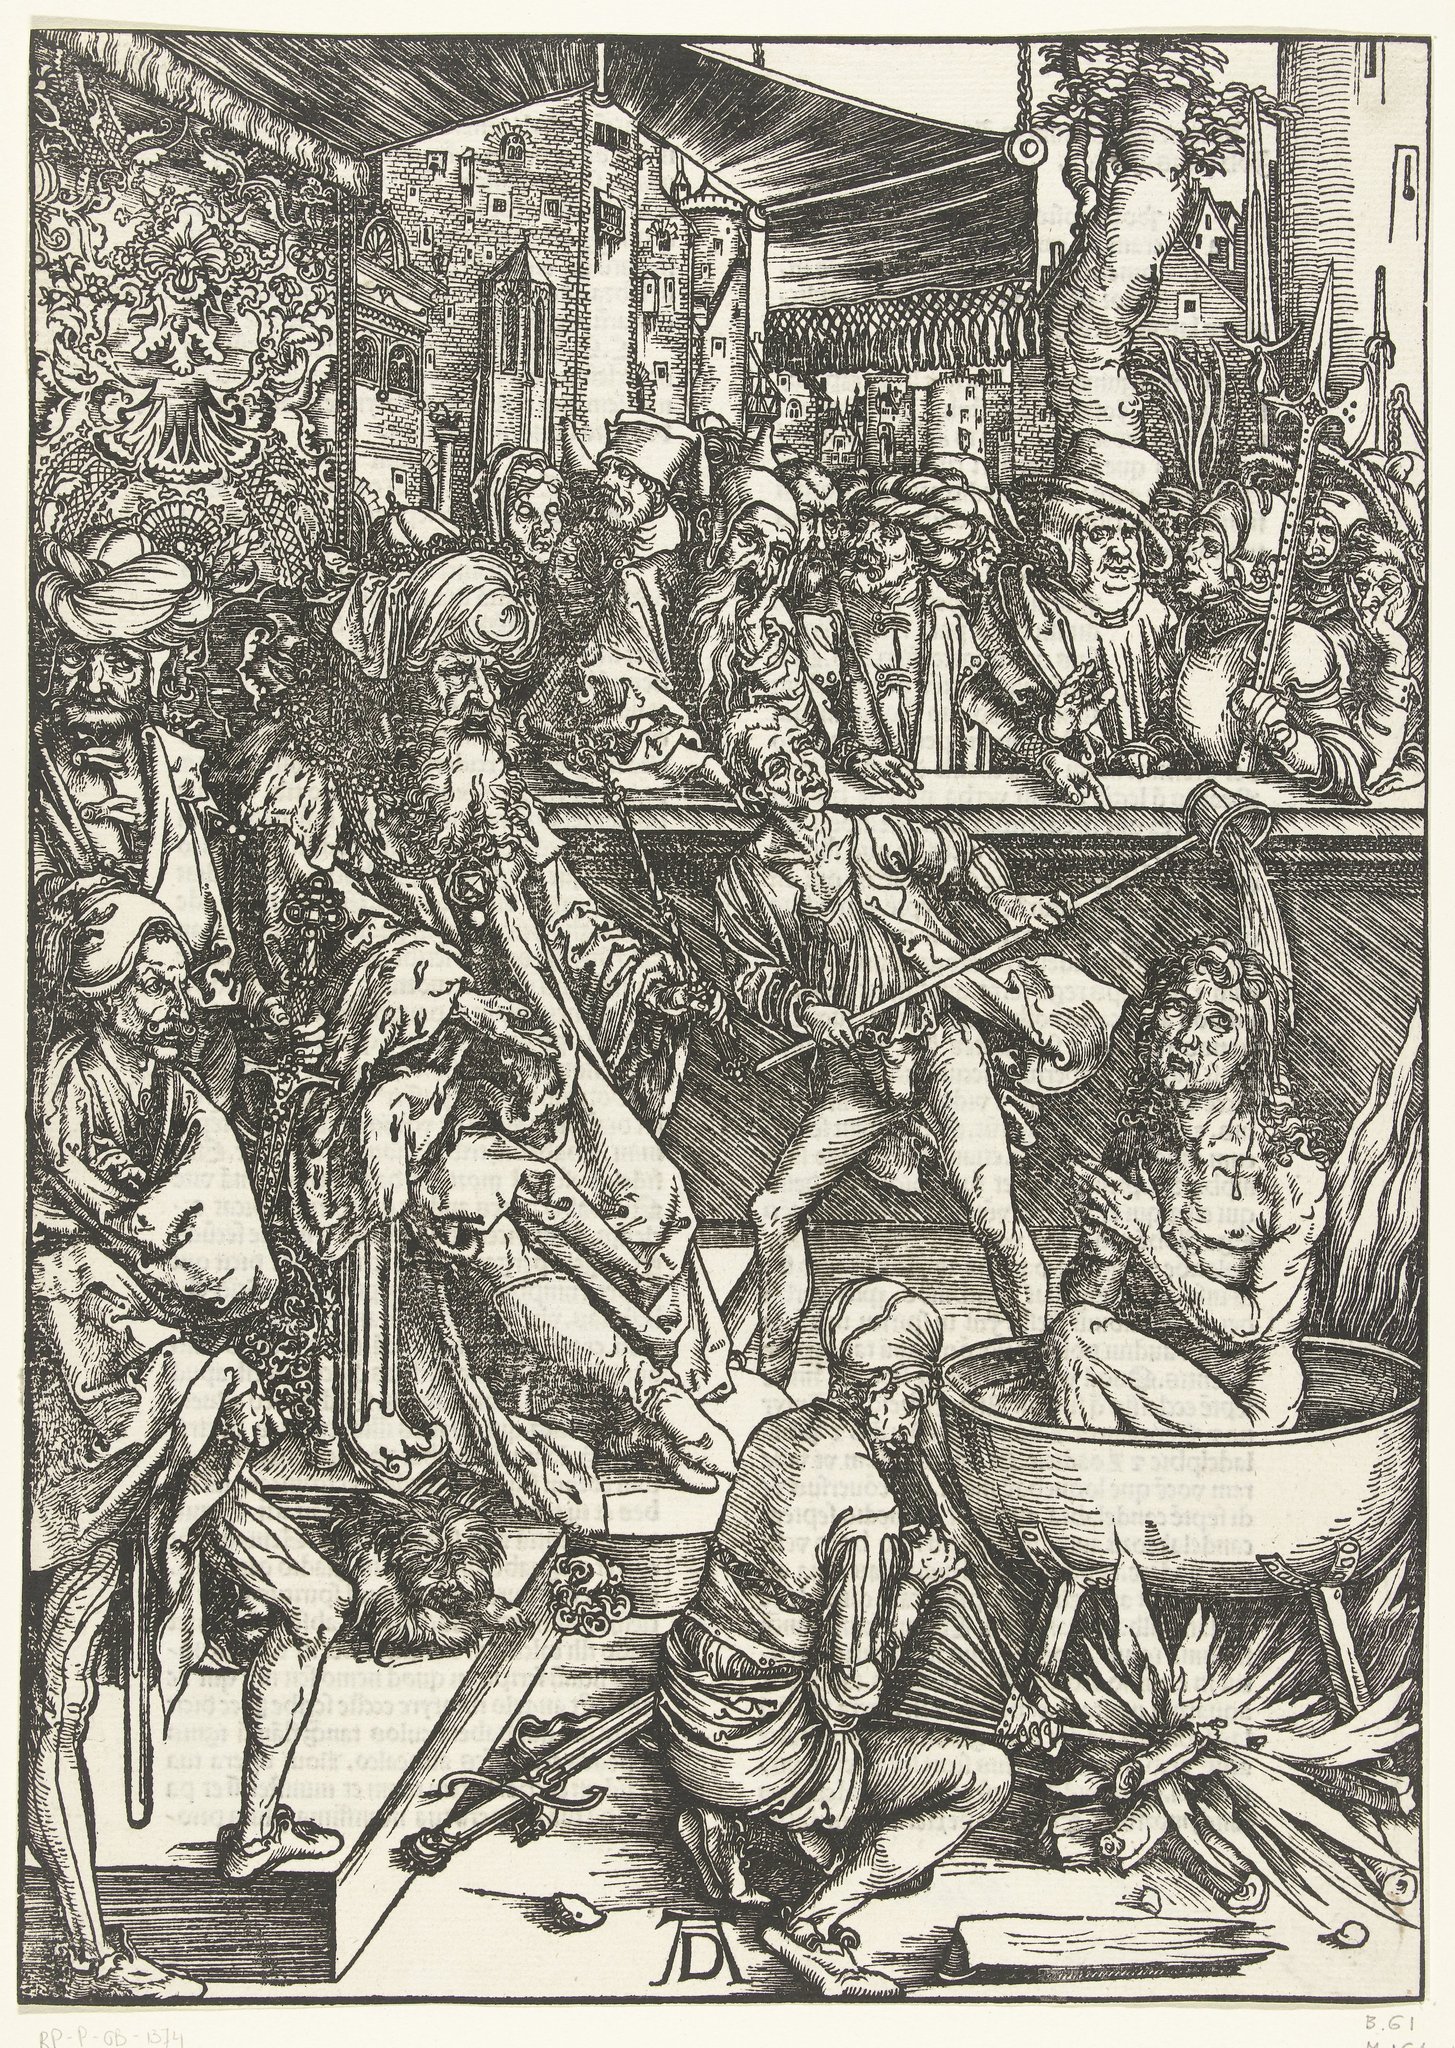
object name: print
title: Het martelaarschap van Johannes de Evangelist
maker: albrecht dürer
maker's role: draughtsman, painter, print maker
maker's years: 1471-1528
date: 1496-1497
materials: paper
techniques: letterpress printing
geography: nuremberg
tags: martyrdom of john in front of the porta latina: he is put in a cauldron of boiling oil, but remains unharmed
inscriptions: collector's mark: Lugt 240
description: Voor een man op een troon zit Johannes de Evangelist met de handen gevouwen in een ketel die op een vuur staat. Een man houdt met een blaasbalg het vuur hoog, een andere man giet met een grote lepel kokende olie over Johannes. Vele omstanders kijken toe. Op versozijde Latijnse bijbeltekst in gotisch schrift in twee kolommen.